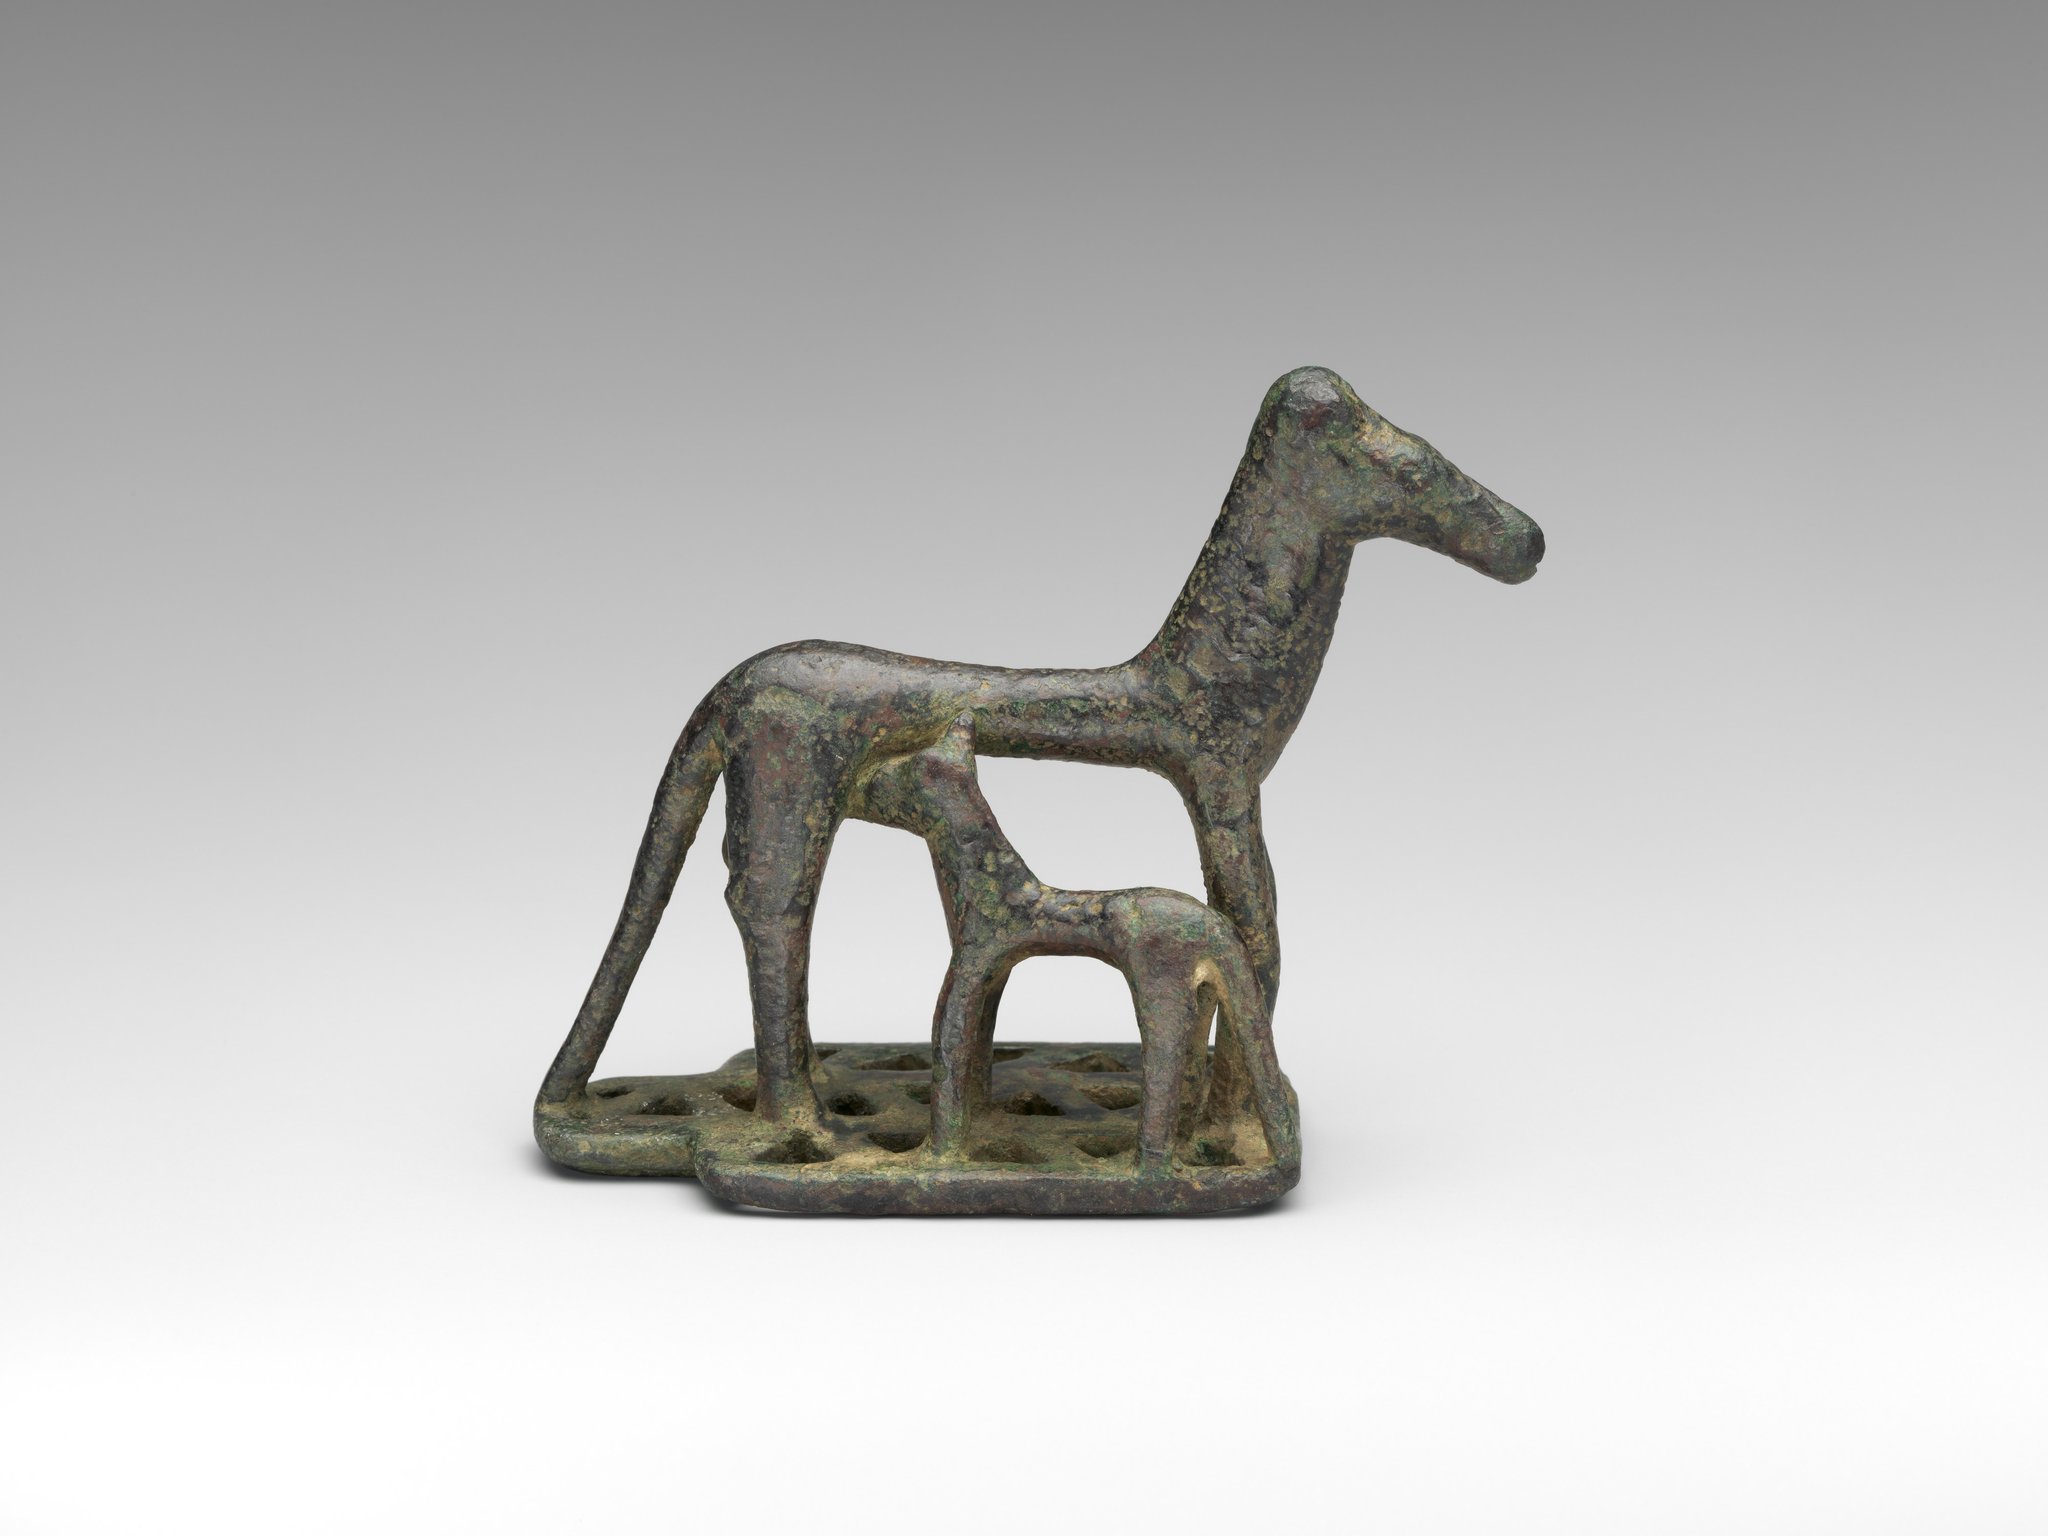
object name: statuette of a horse mare and foal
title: Bronze mare and foal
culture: greek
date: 734-701 BCE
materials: bronze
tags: horses